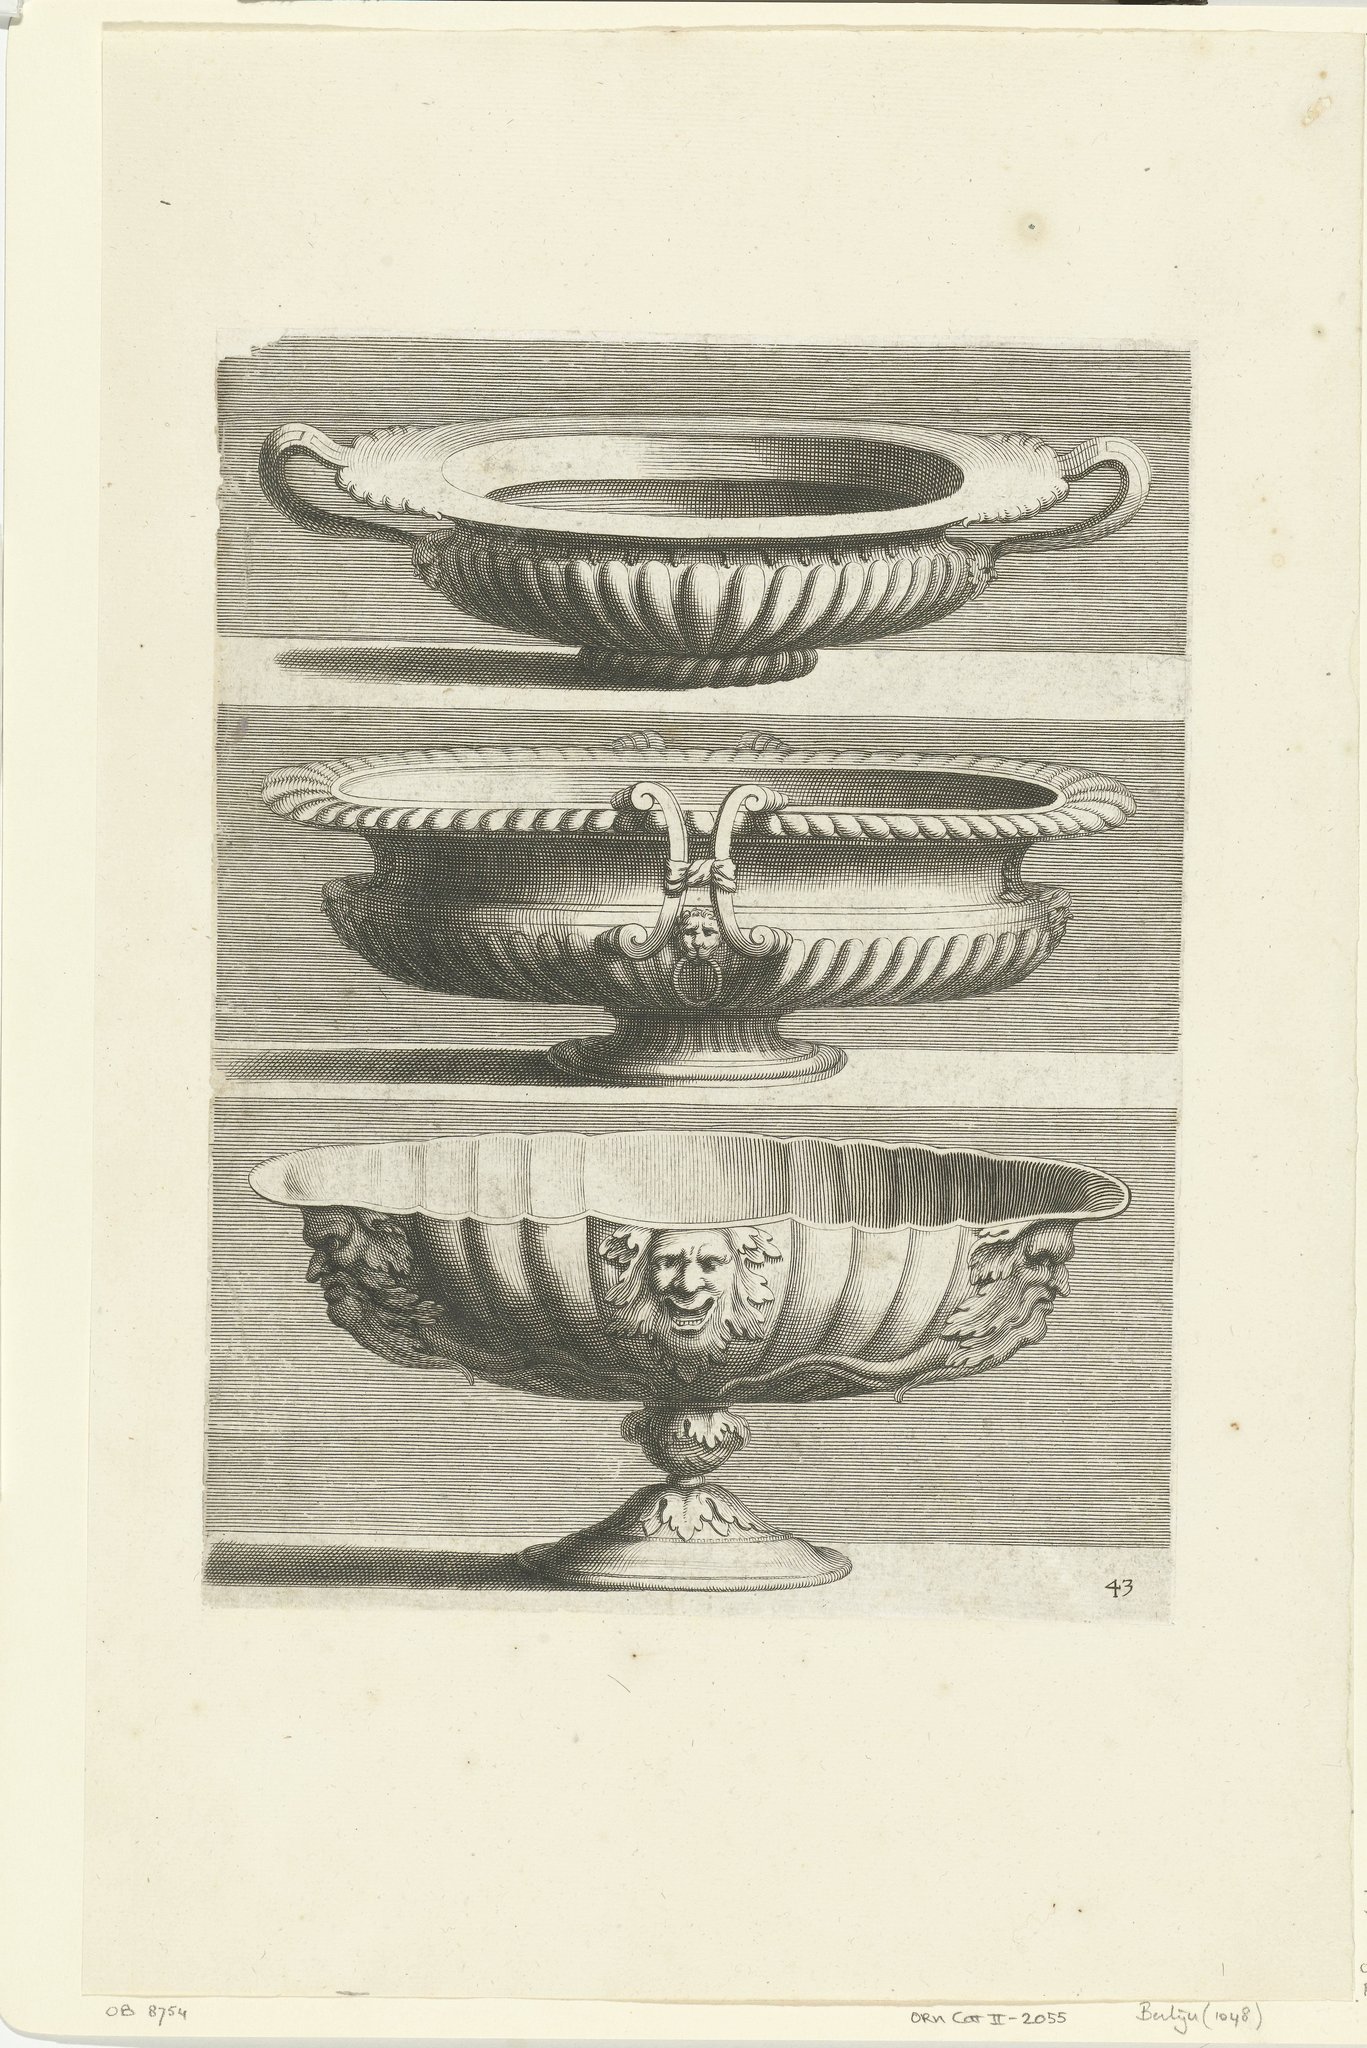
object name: print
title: Drie schalen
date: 1667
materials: paper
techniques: engraving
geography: france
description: De onderste schaal is gedecoreerd met drie maskers tussen bladeren. Blad 43 uit serie van 25 bladen, genummerd: II (voorheen 26), 27-50.